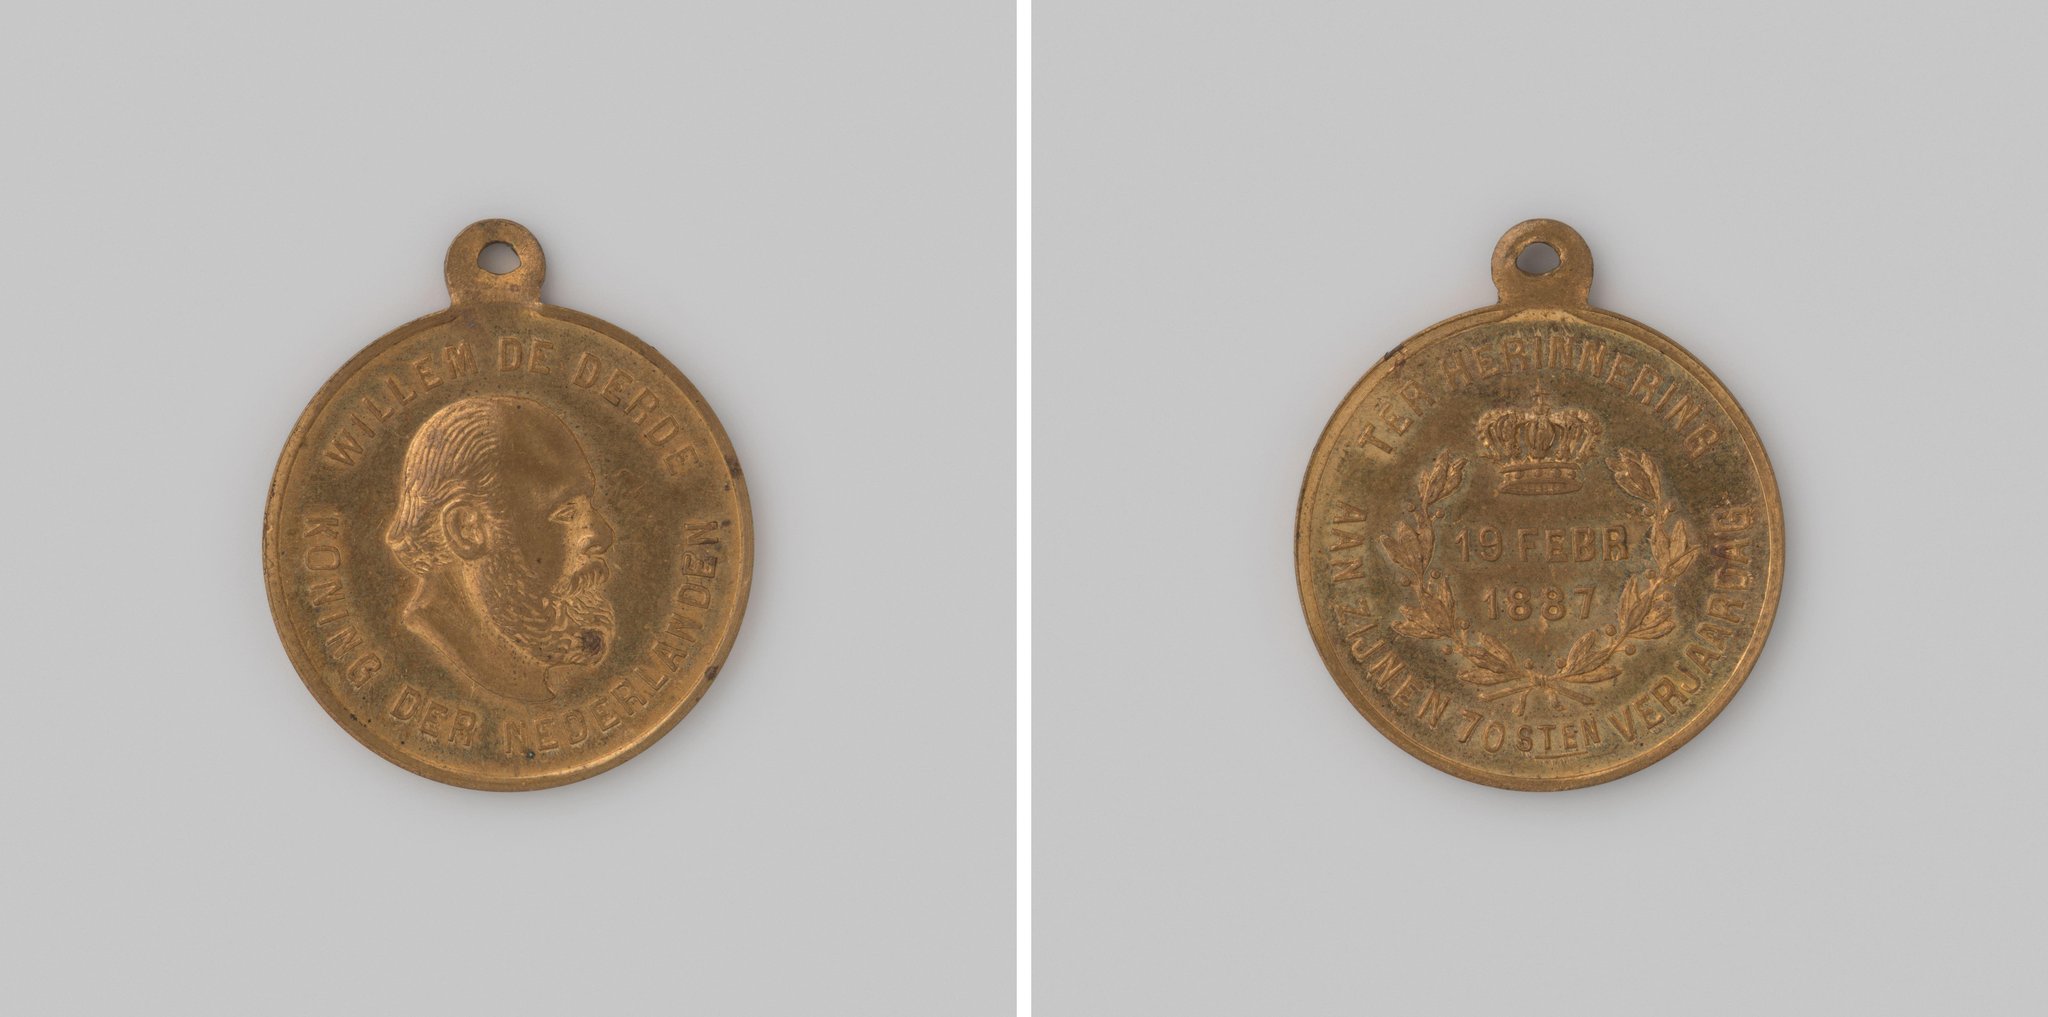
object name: history medal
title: Zeventigste verjaardag van Koning Willem III 1887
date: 1887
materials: brass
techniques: striking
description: Messing penning met draagoog, op de voorzijde het portret van Willem III naar rechts met omschrift, op de keerzijde twee regels tekst onder een kroon tussen lauwertakken, met omschrift.